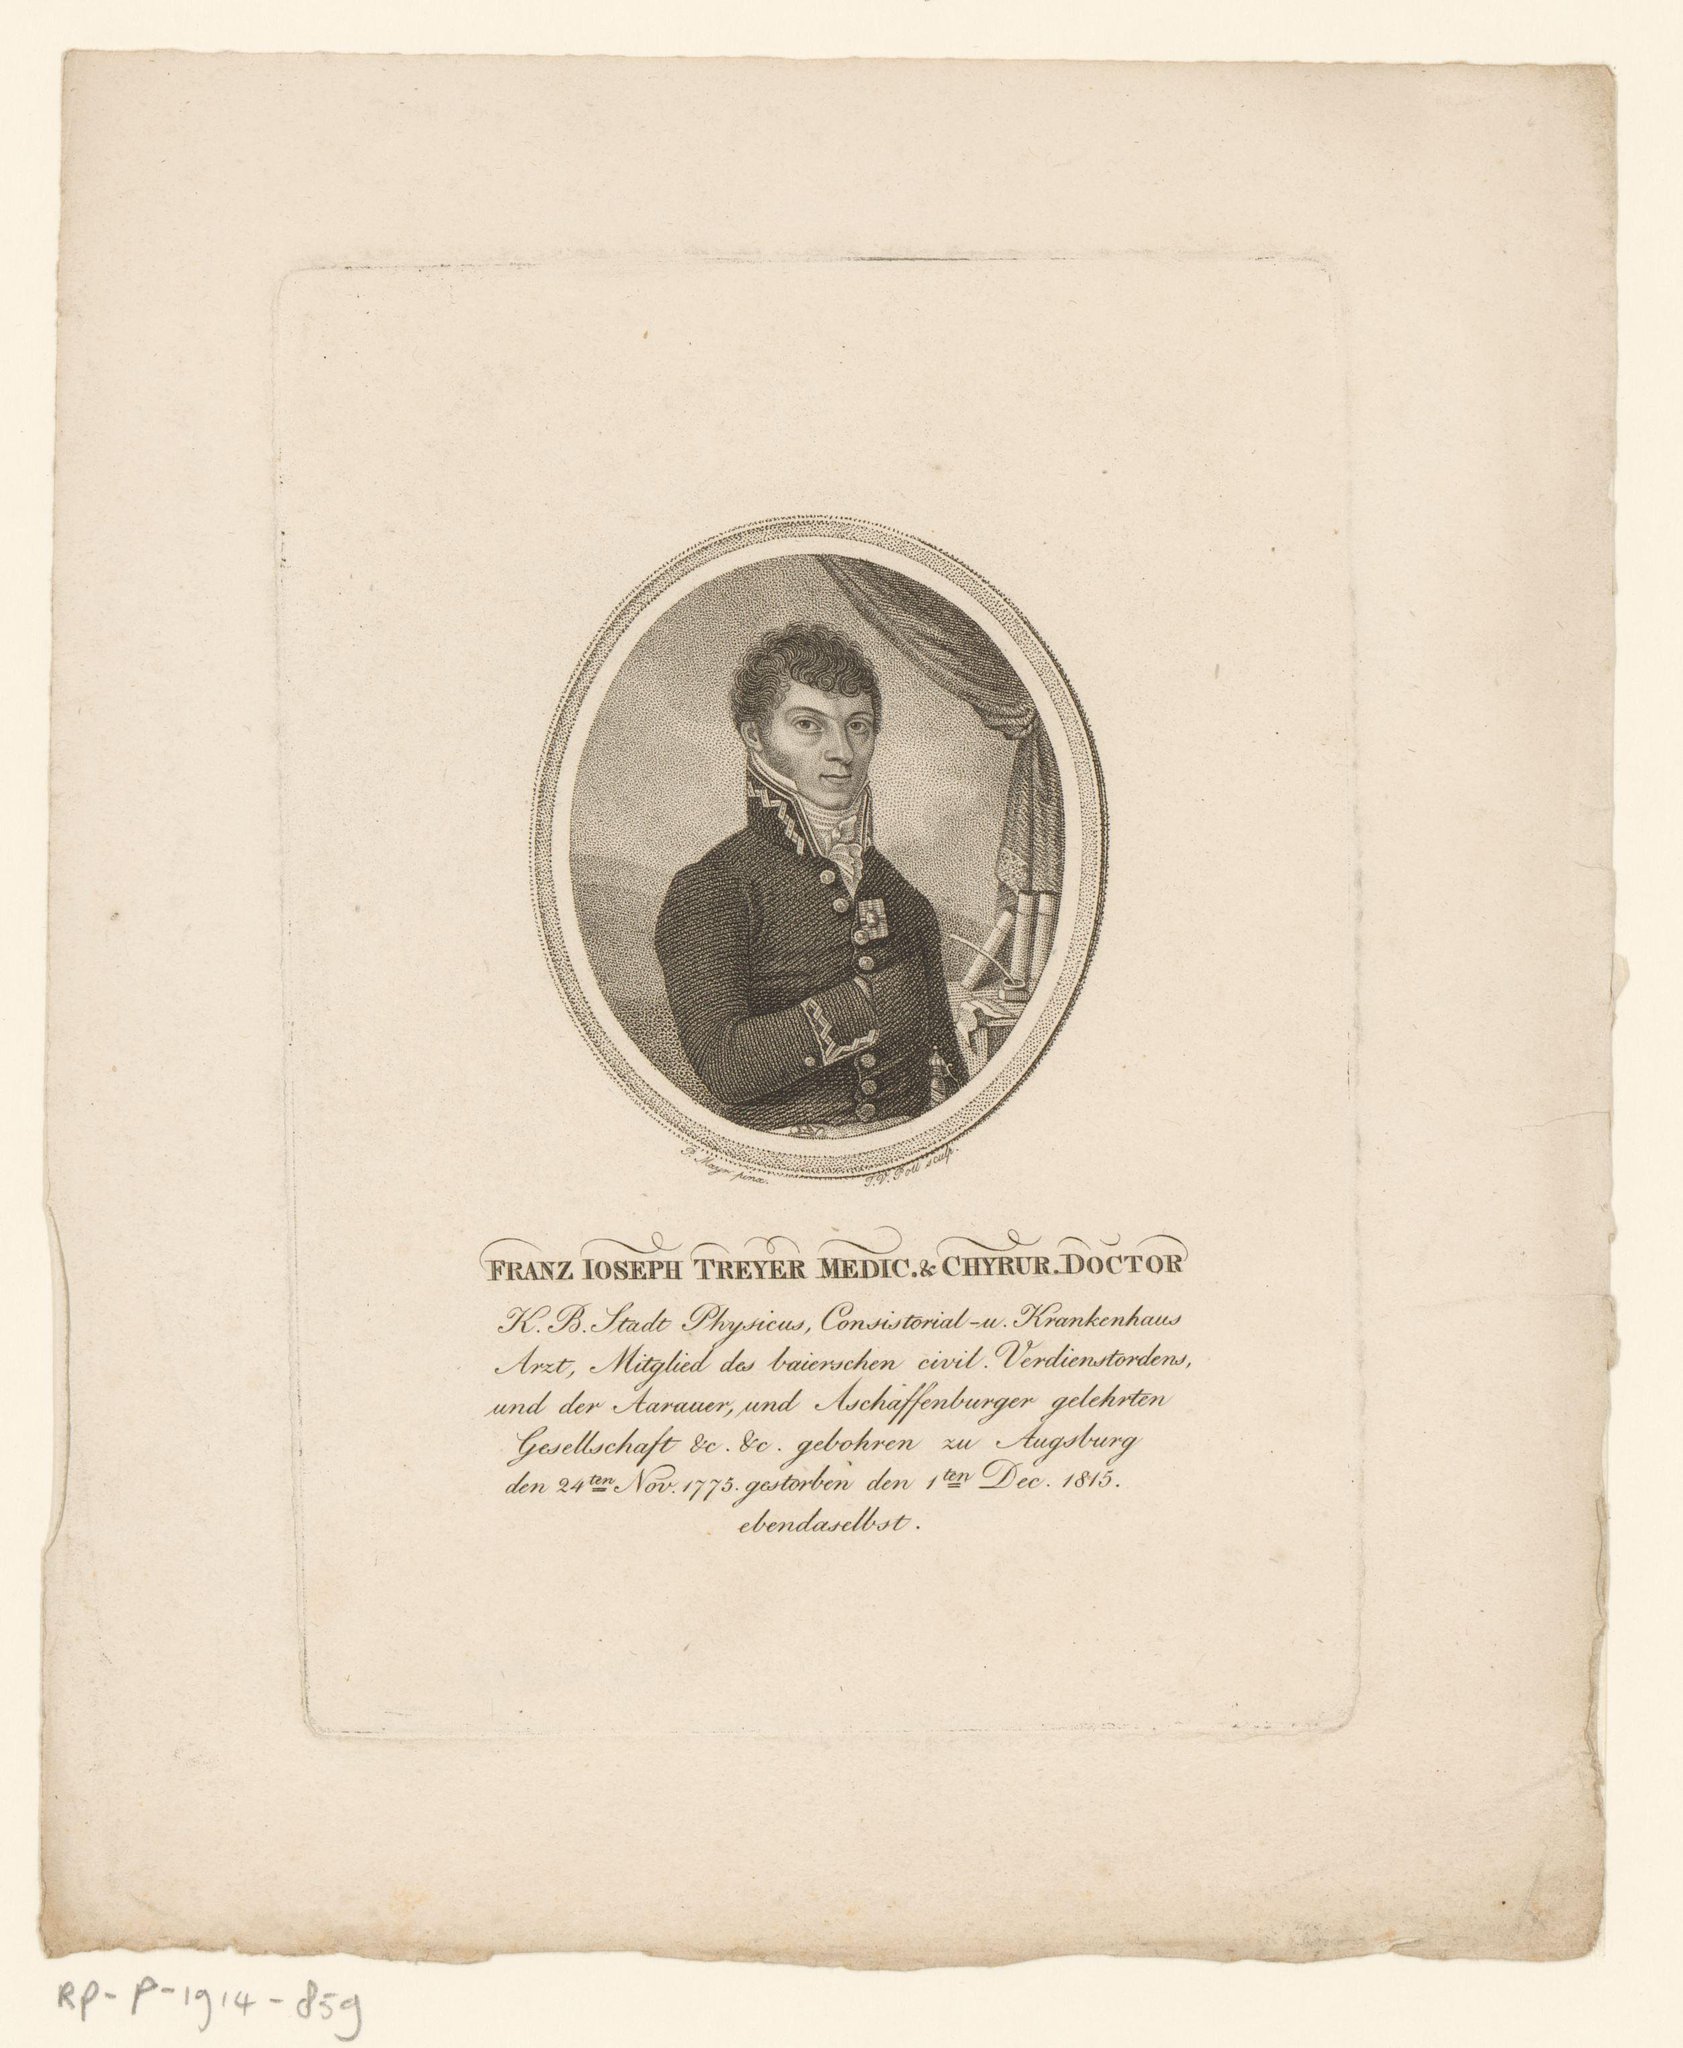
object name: print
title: Portret van Franz Josef Treyer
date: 1790-1880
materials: paper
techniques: engraving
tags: historical persons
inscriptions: collector's mark: Lugt 2228